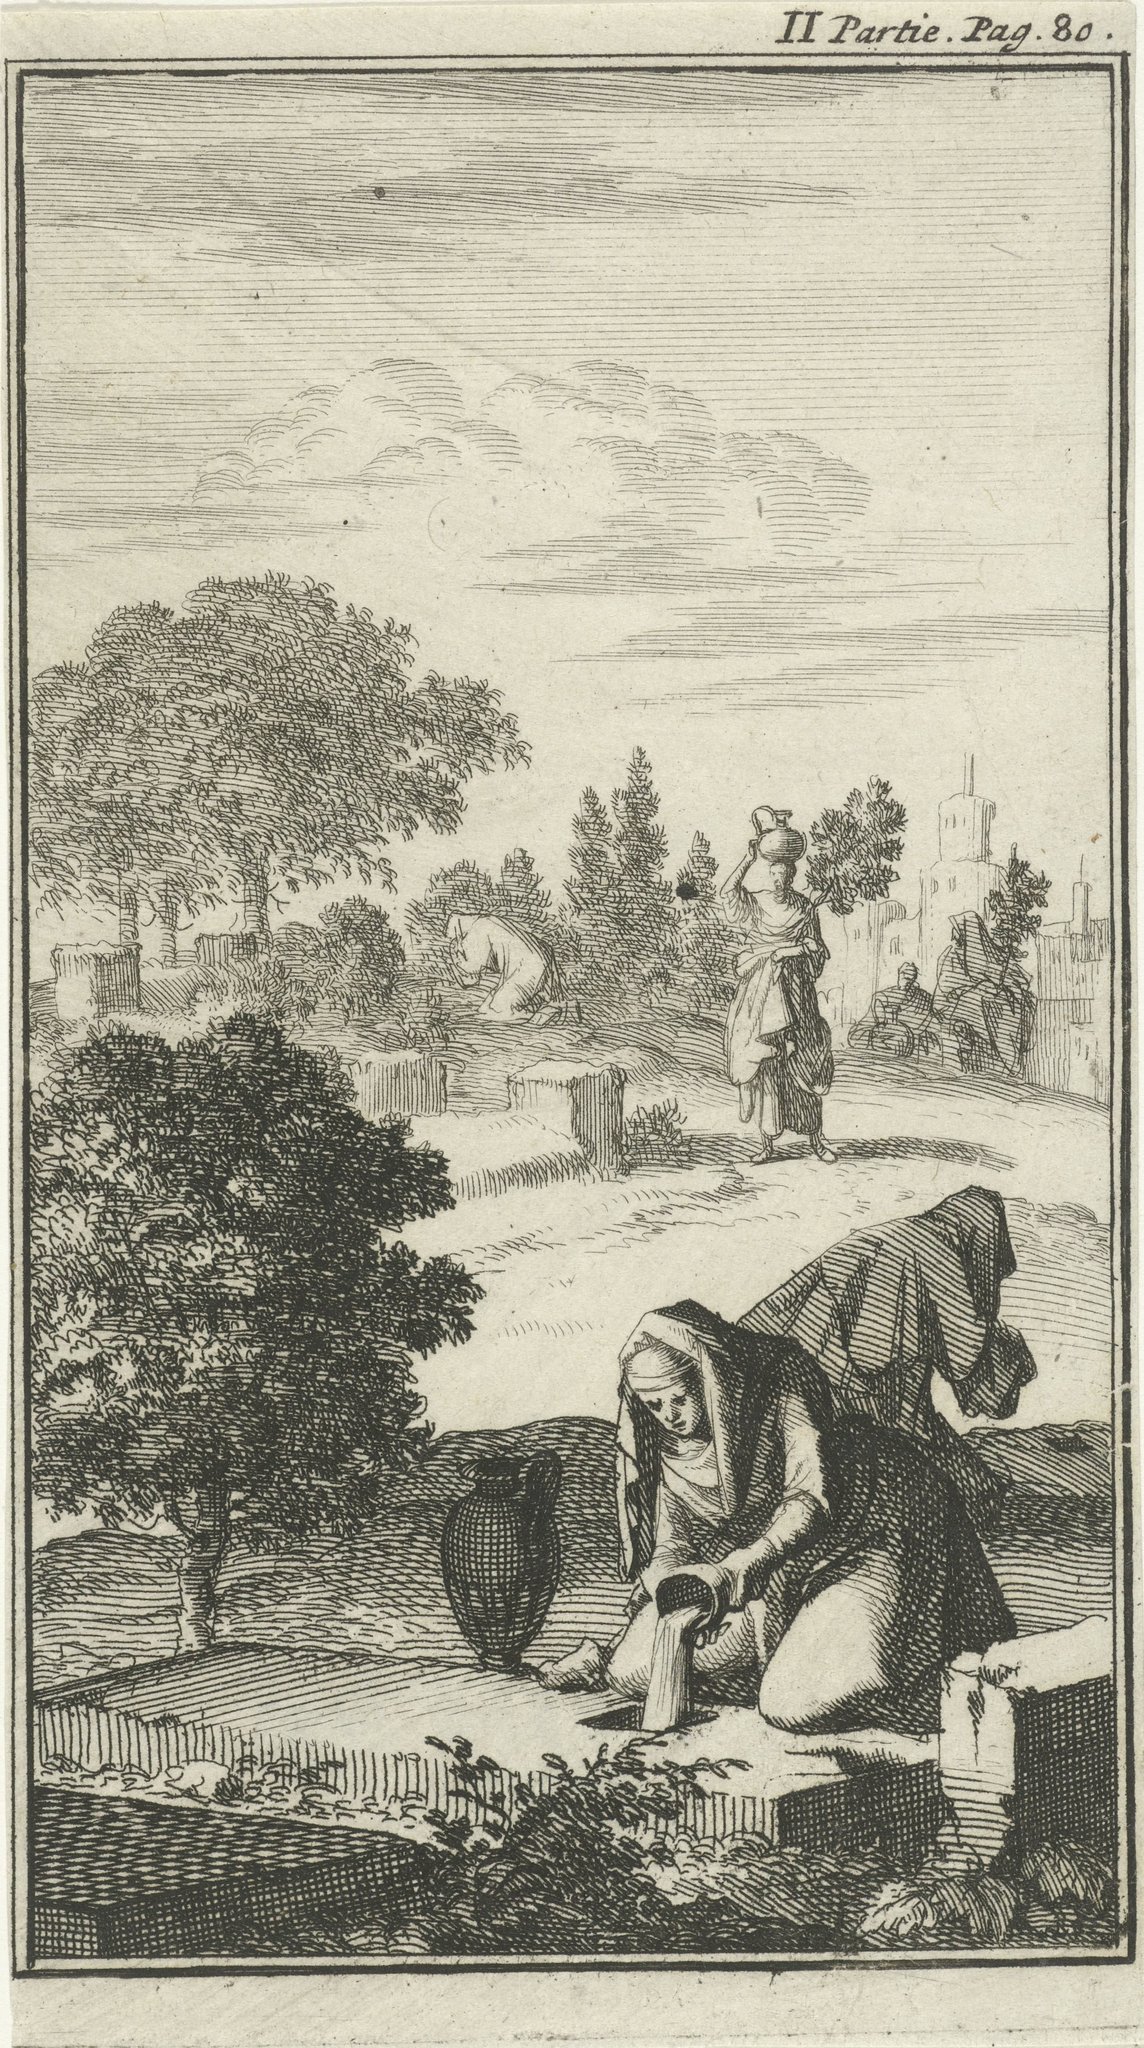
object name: book illustration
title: Turkse vrouwen op het kerkhof te Damascus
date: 1689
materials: paper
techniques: etching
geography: paris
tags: churchyard, cemetery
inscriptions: collector's mark: Lugt 2228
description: Illustratie uit: Thevenot, Jean de. Voyages Tant en Europe qu'en Asie et en Afrique, 4 delen. Parijs: Charles Angot, 1689, dl. III.